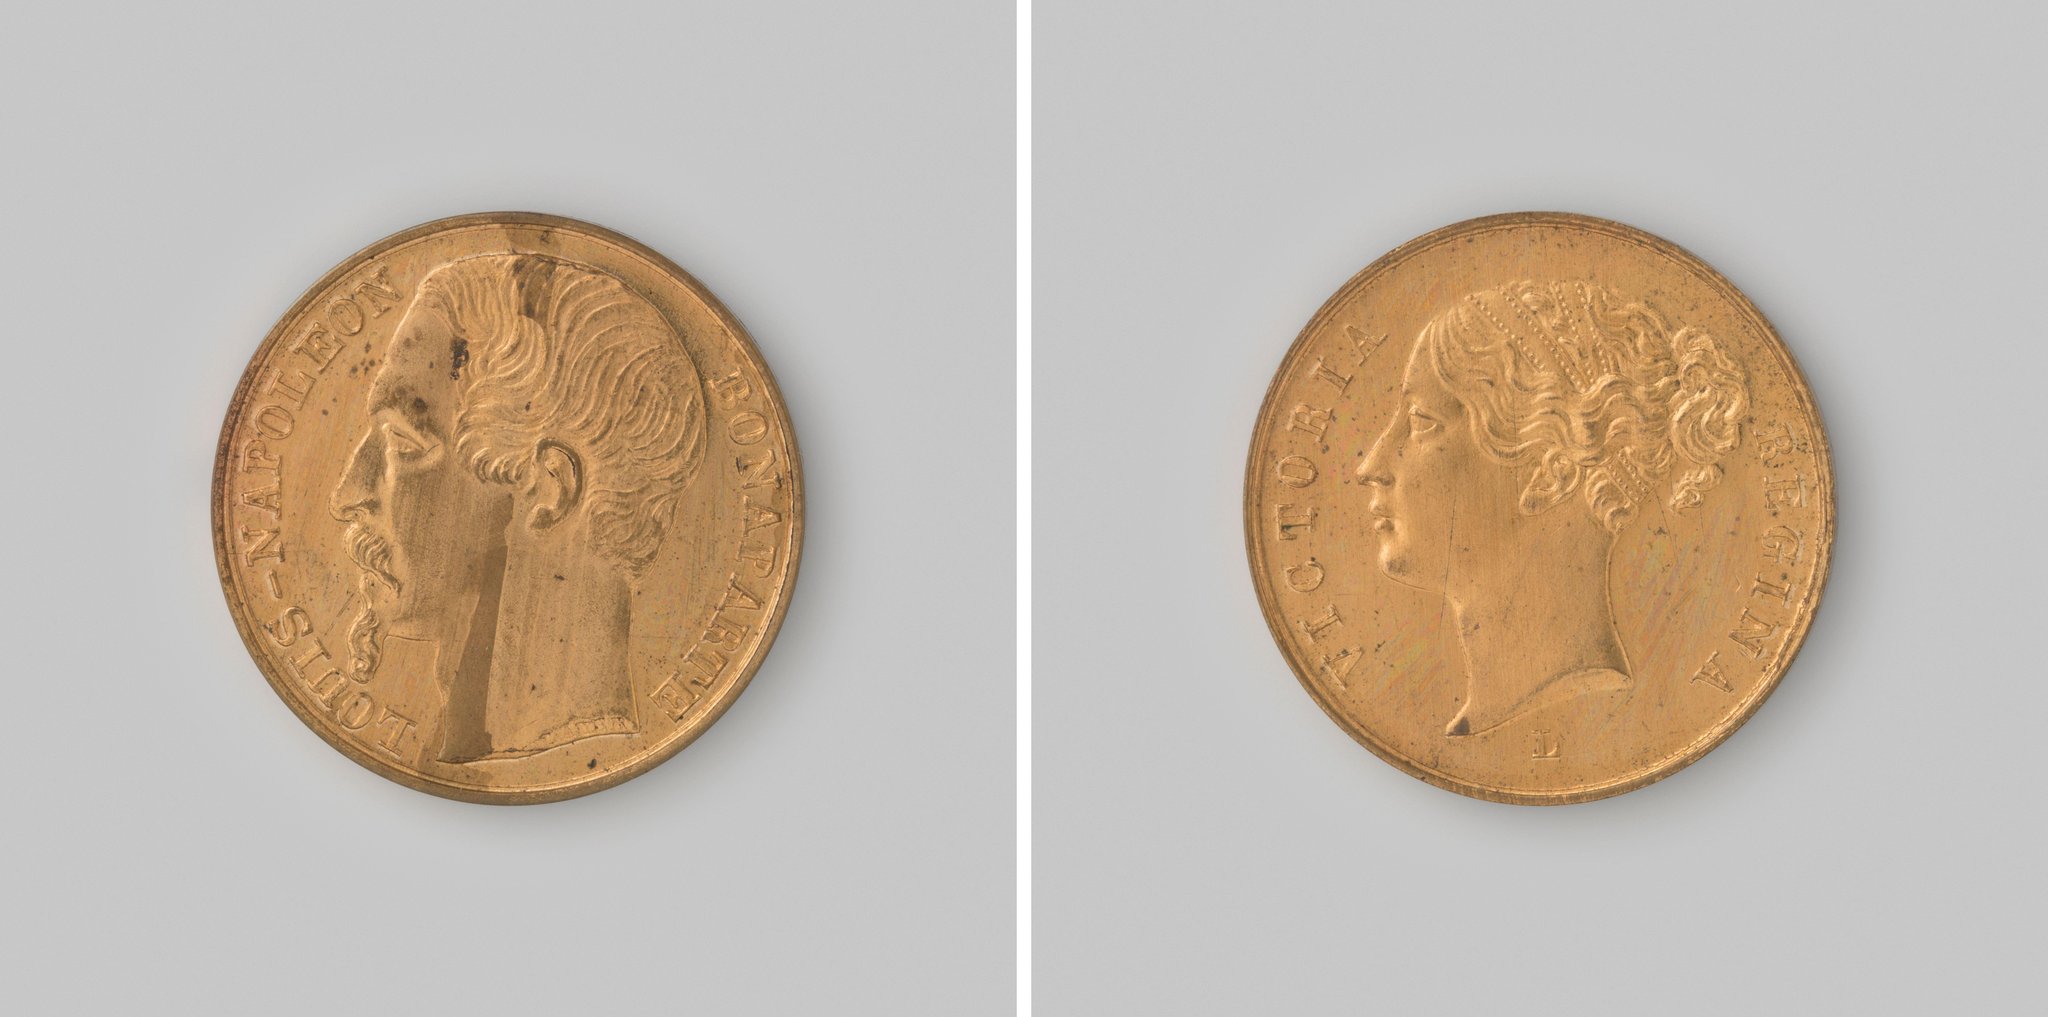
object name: gaming counter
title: Speelpenning met president Lodewijk Napoleon Bonaparte en koningin Victoria ca 1850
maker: johann jakob lauer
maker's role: die cutter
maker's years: 1788-1863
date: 1848-1852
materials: brass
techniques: striking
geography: nuremberg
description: Verguld messing penning,op de voorzijde het portret van president Bonaparte naar links met omschrift, op de keerzijde het portret van koningin Victoria naar links met omschrift.